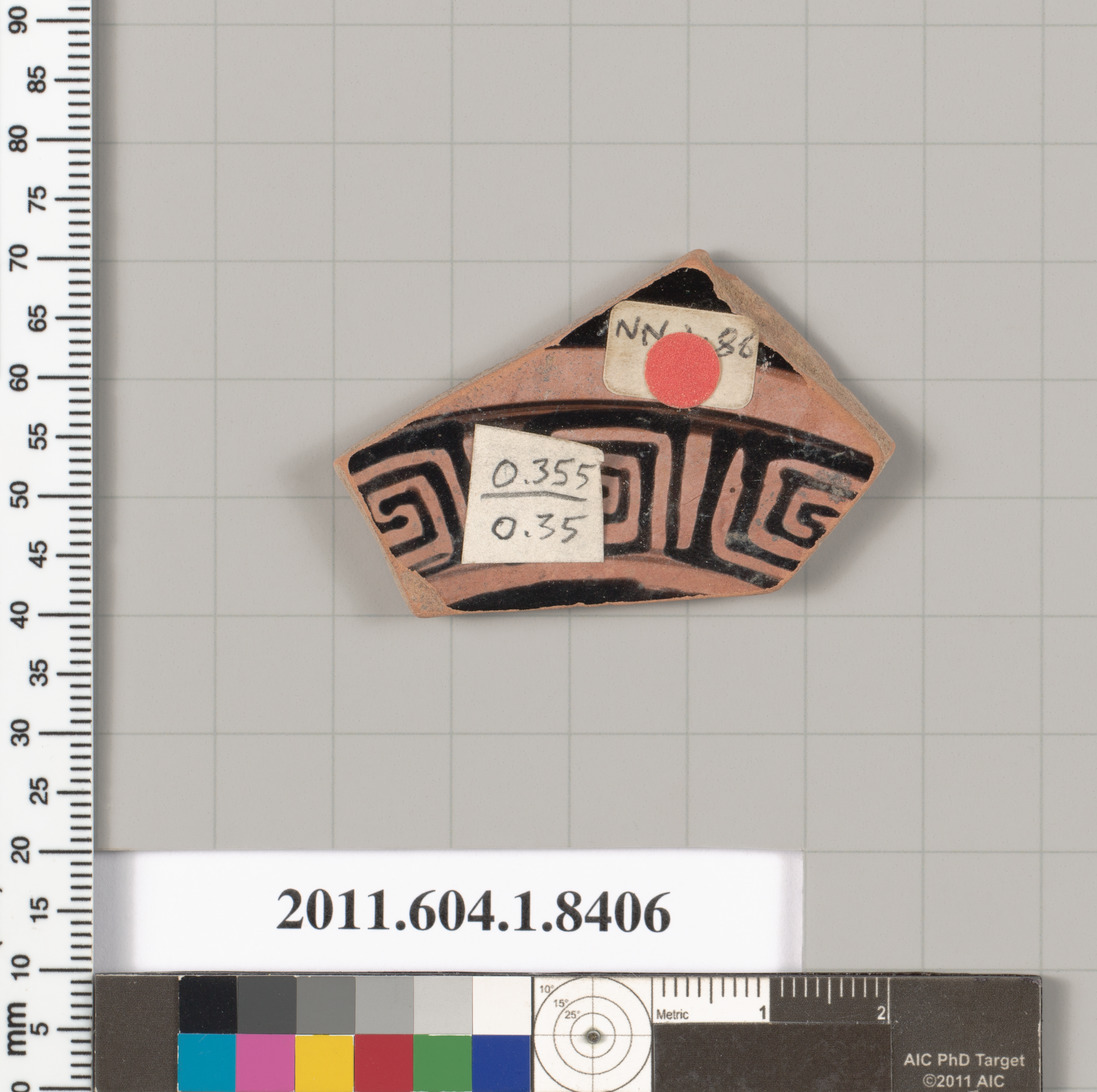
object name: kylix fragment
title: Terracotta fragment of a kylix (drinking cup)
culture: greek, attic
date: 400-351 BCE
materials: terracotta